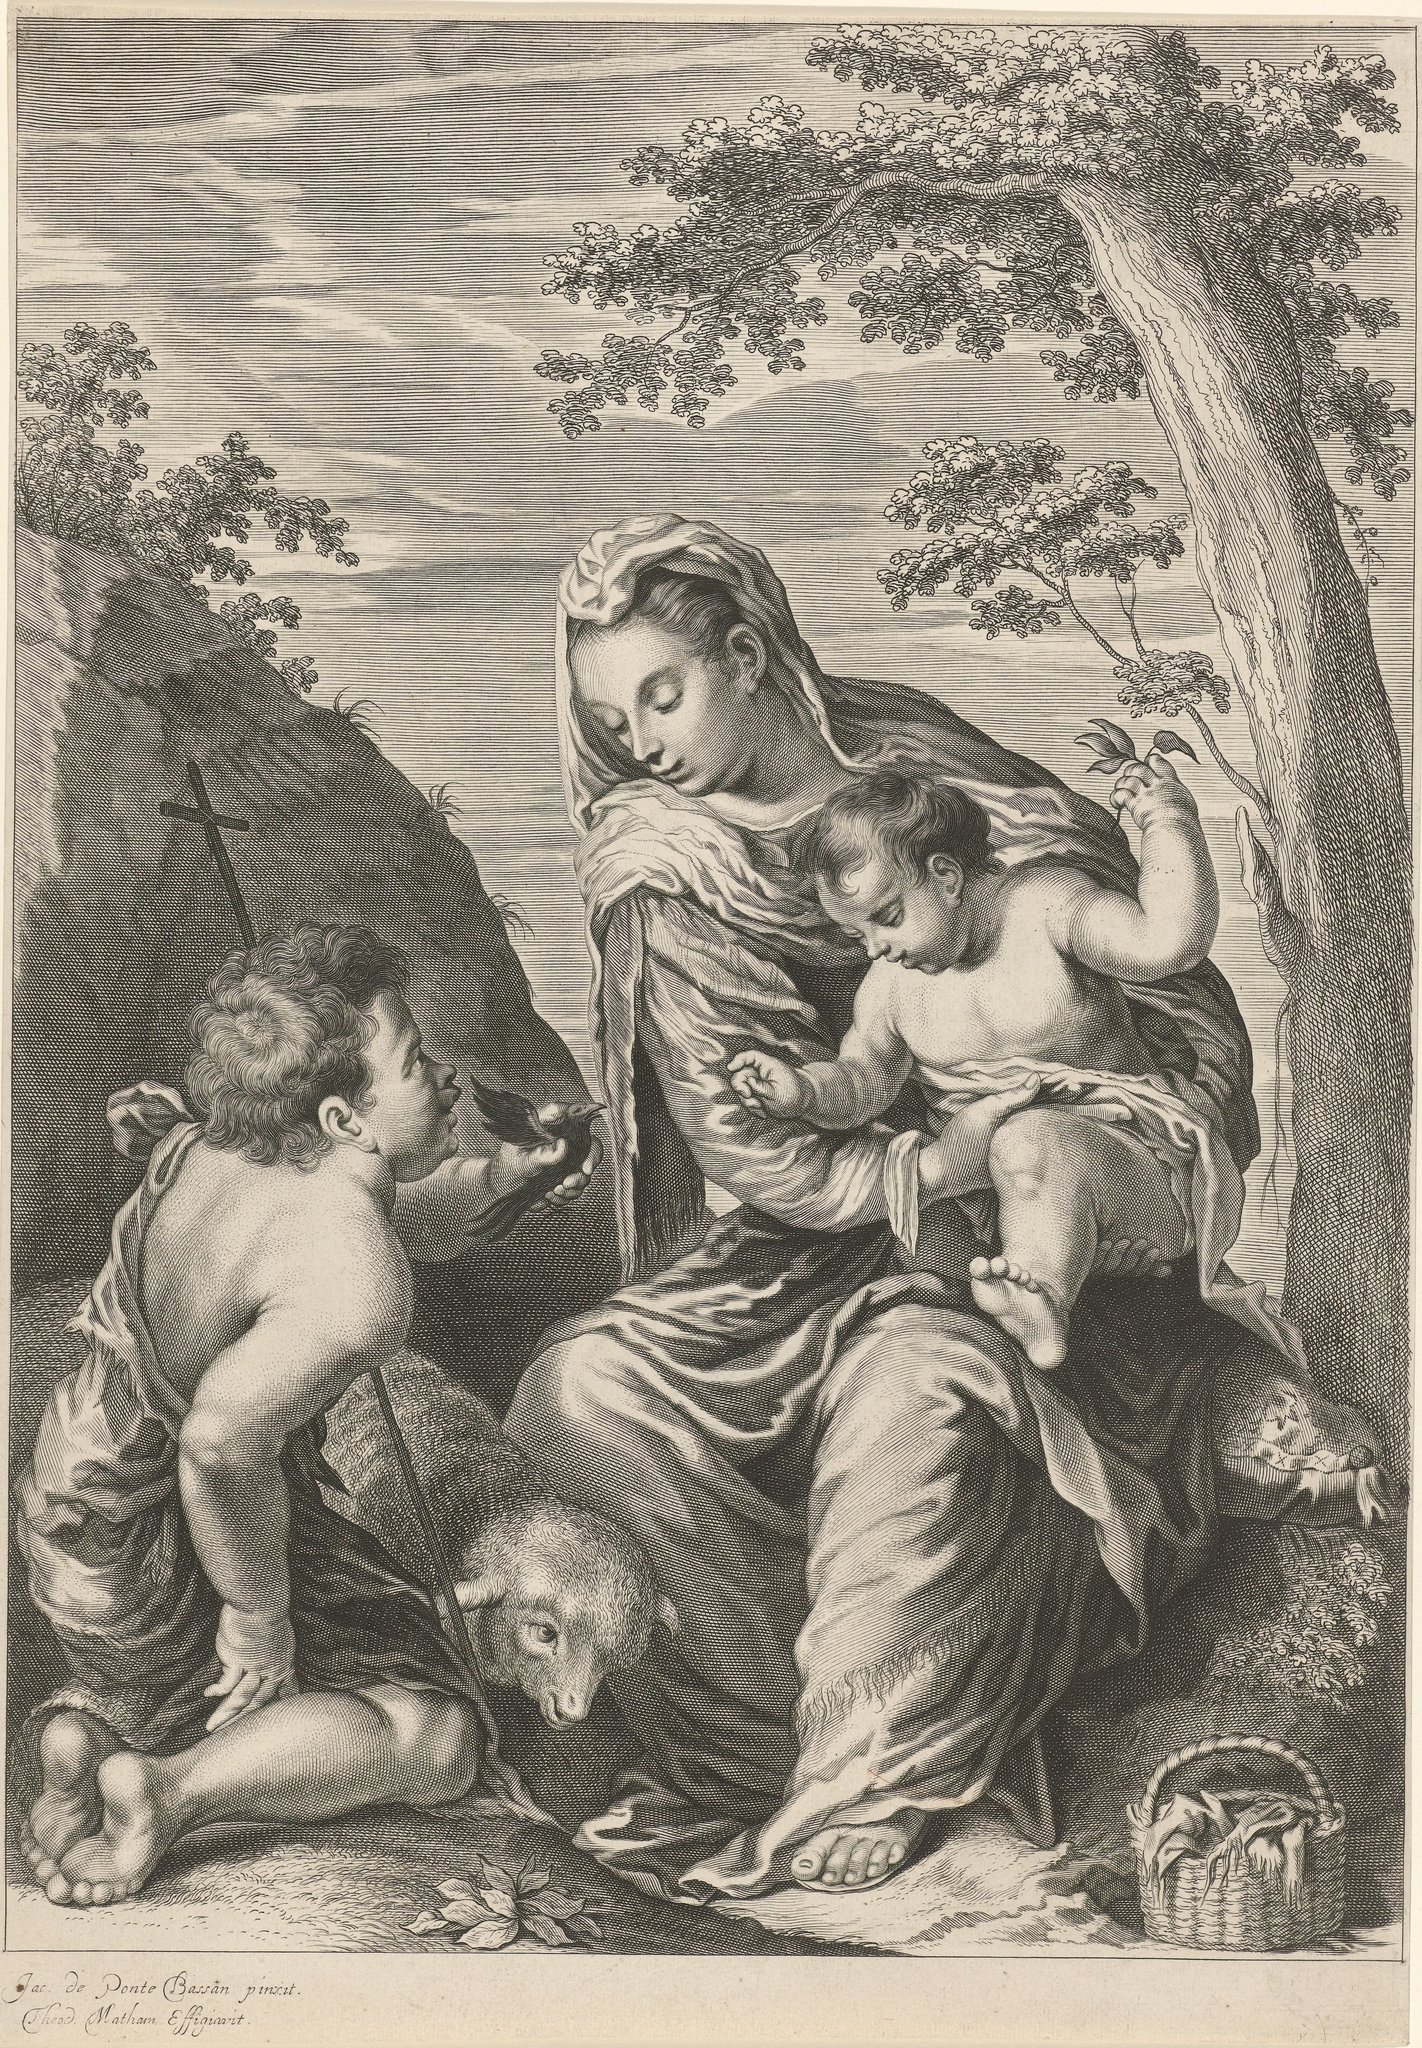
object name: print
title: Maria met Kind en Johannes de Doper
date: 1615-1676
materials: paper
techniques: engraving, etching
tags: mary and the christ-child with john the baptist (as child)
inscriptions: collector's mark: Lugt 240, inscription: ‘Pag 111 V (?)’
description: Maria met Kind zittend bij een boom. Voor haar het kind Johannes dat het Christuskind een vogel aanbiedt.